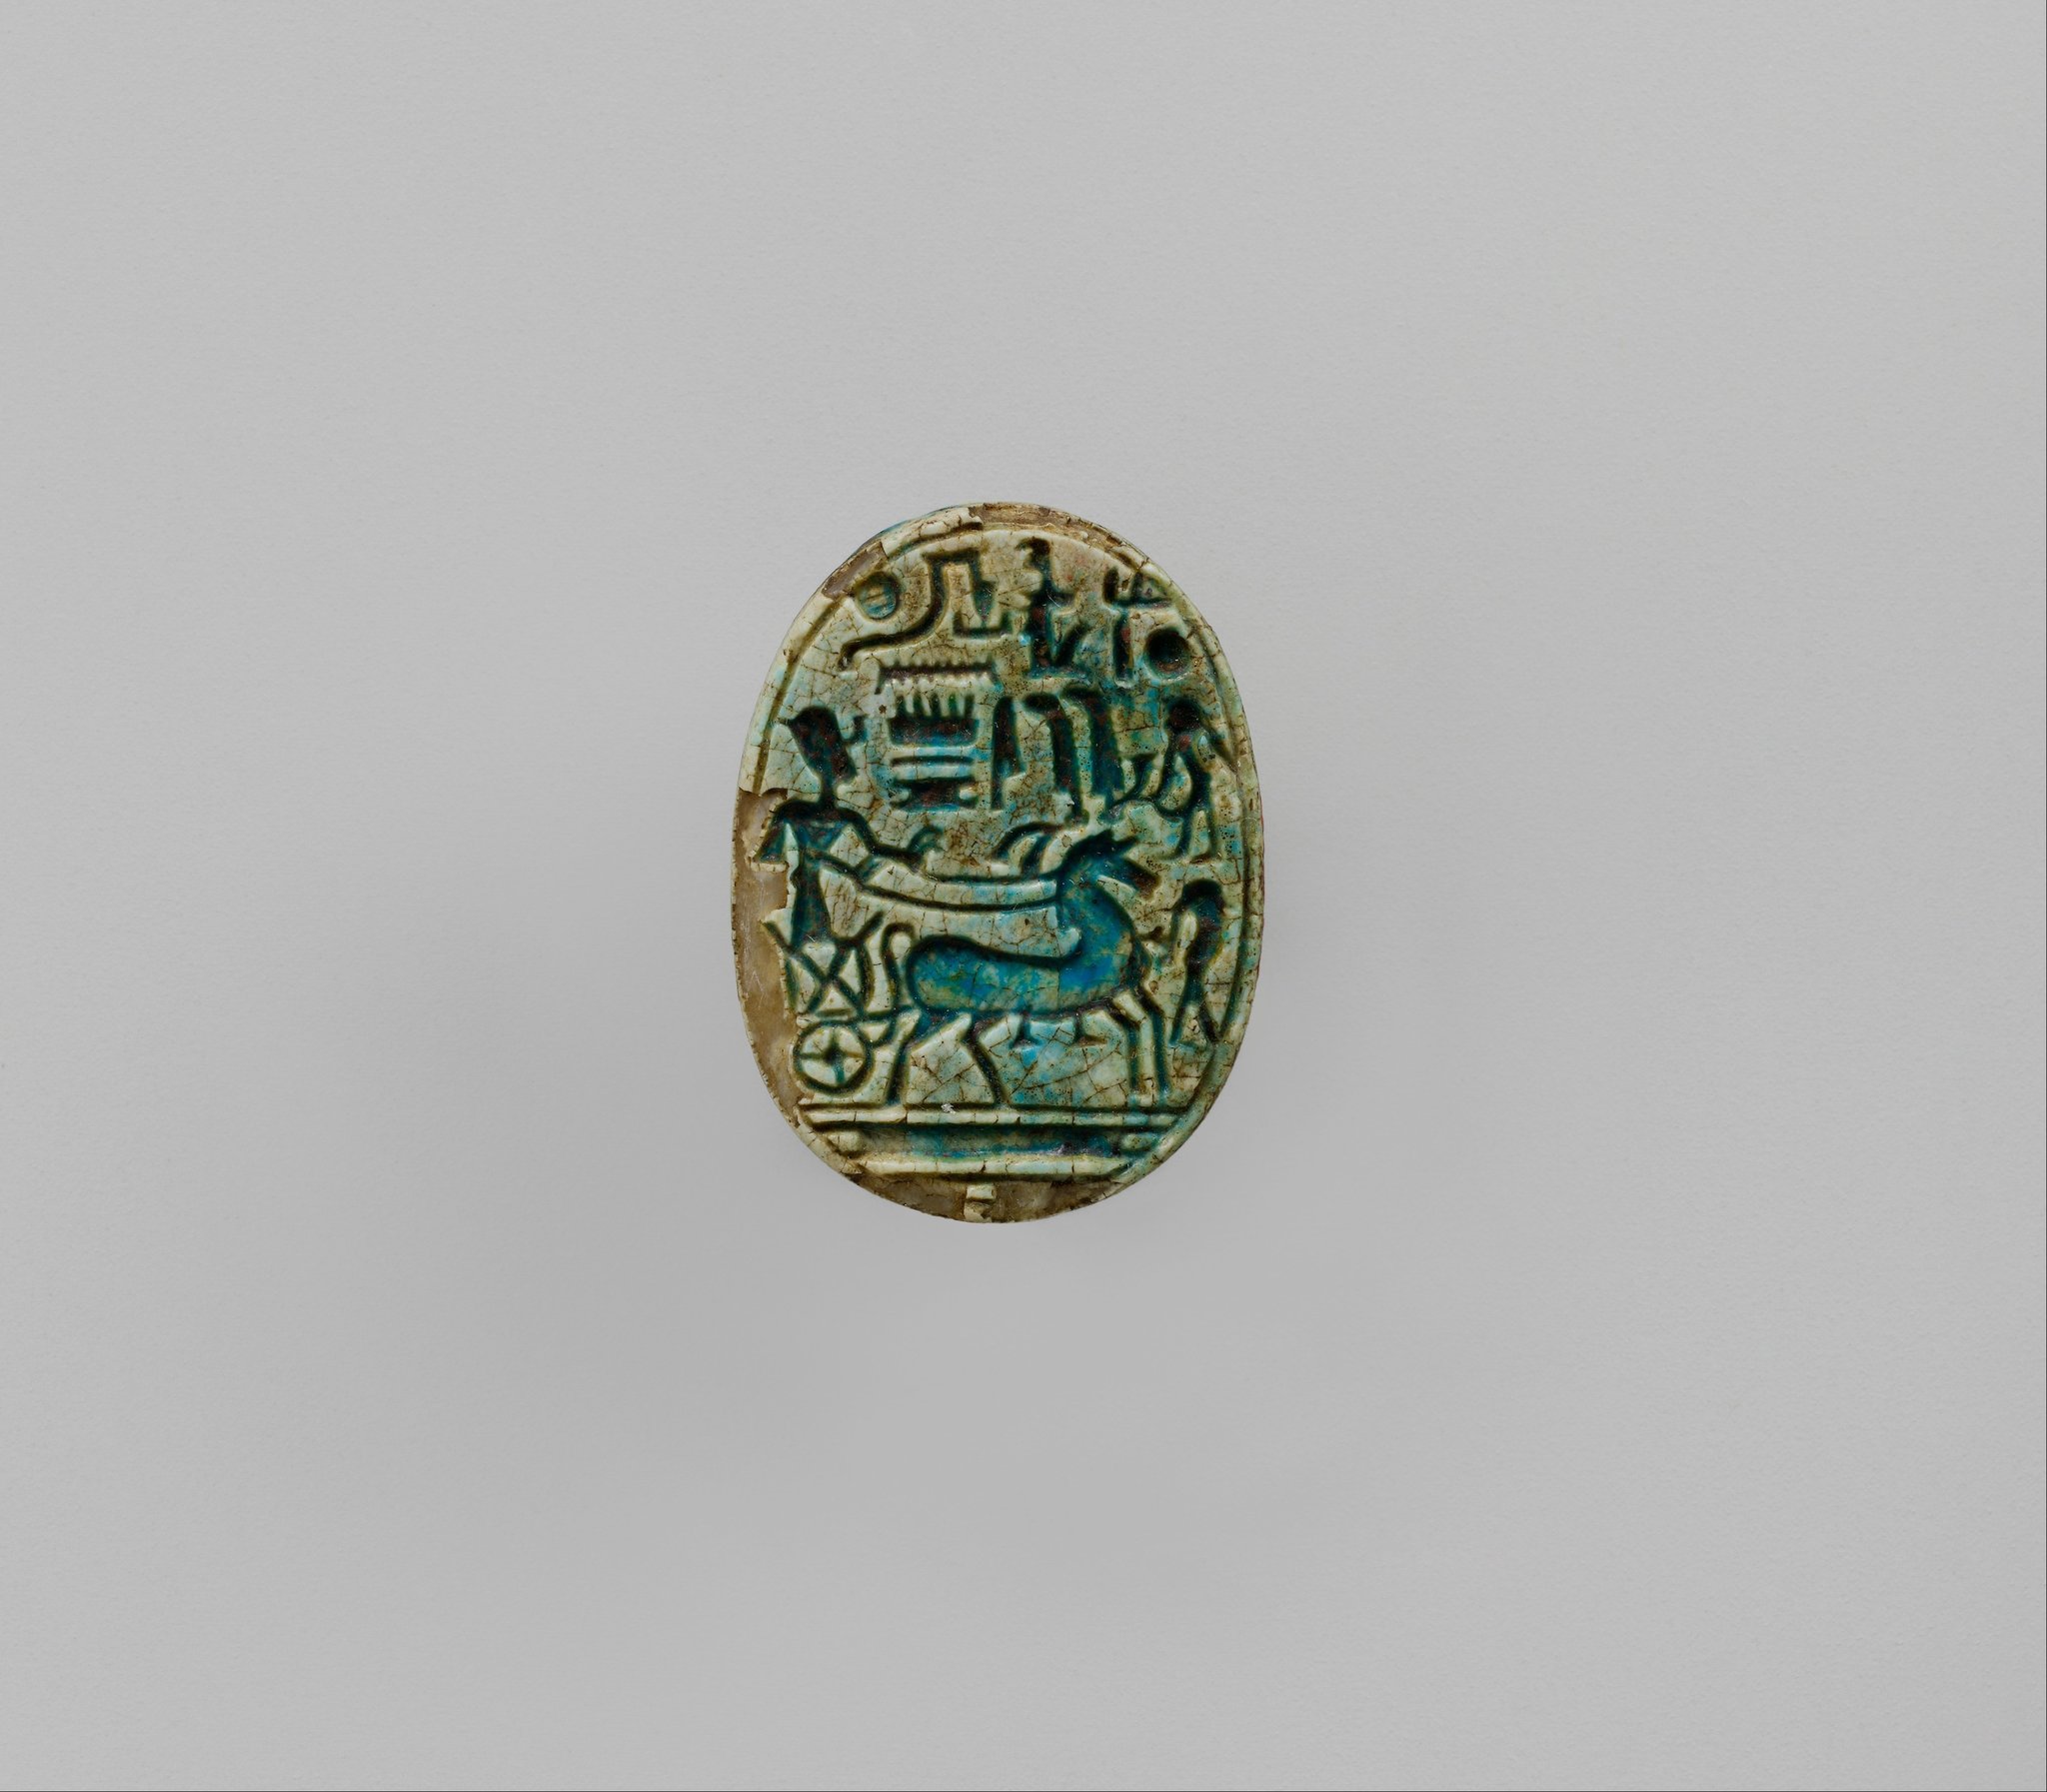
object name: scarab, ramesses ii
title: Scarab Inscribed With the Prenomen of Ramesses II and depicting the king in his chariot trampling an enemy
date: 1279-1213 BCE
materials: glaze, stone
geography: egypt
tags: hieroglyphs,scarabs